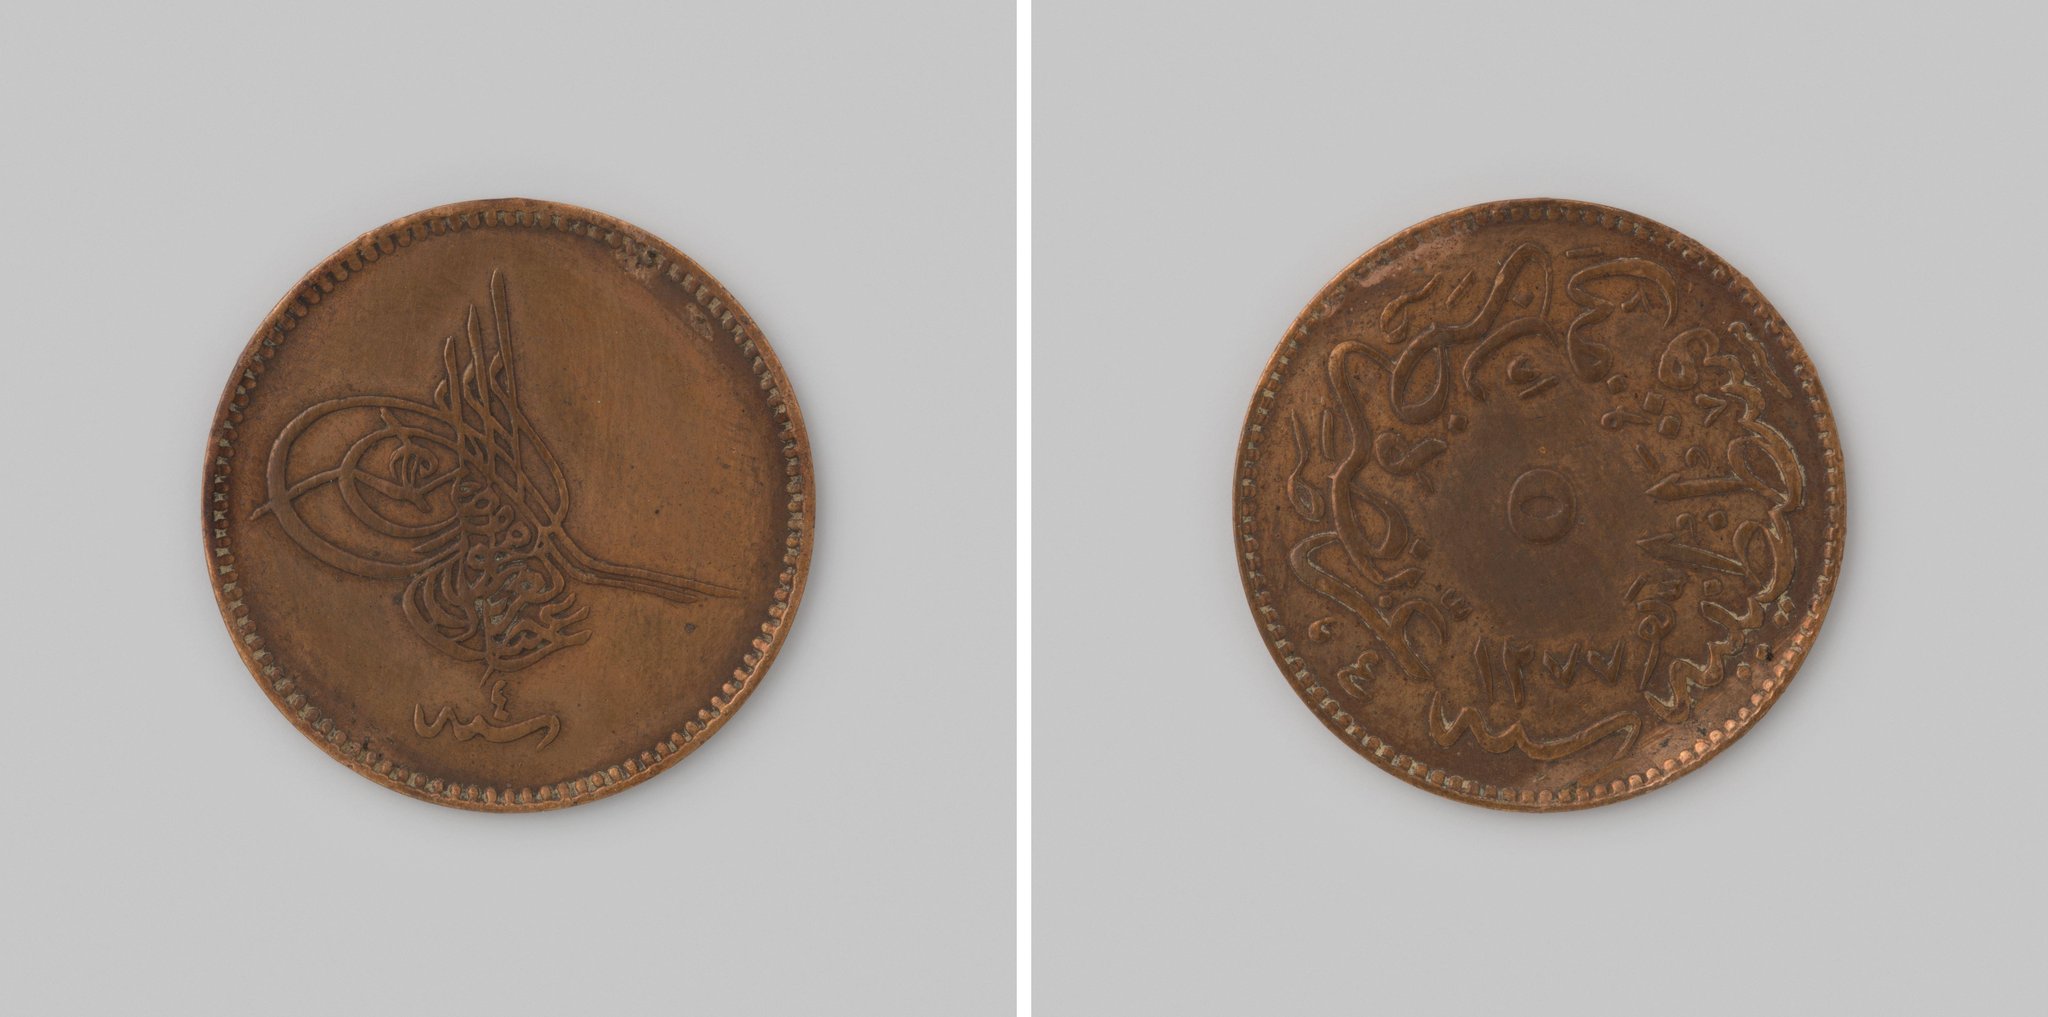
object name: coin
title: 5 para uit Turkije van sultan Abdul Aziz, regeringsjaar 4 [=1864]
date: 1864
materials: copper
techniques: striking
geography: constantinople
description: Koperen munt. Voorzijde: tughra. Onder tughra regeringsjaar-aanduiding:4. Keerzijde: binnen omschrift in Arabische letters waarde-aanduiding: 5. In omschrift muntplaats-aanduiding: Constantinopel en aanduiding jaar van aantreden: 1277 [=1861].